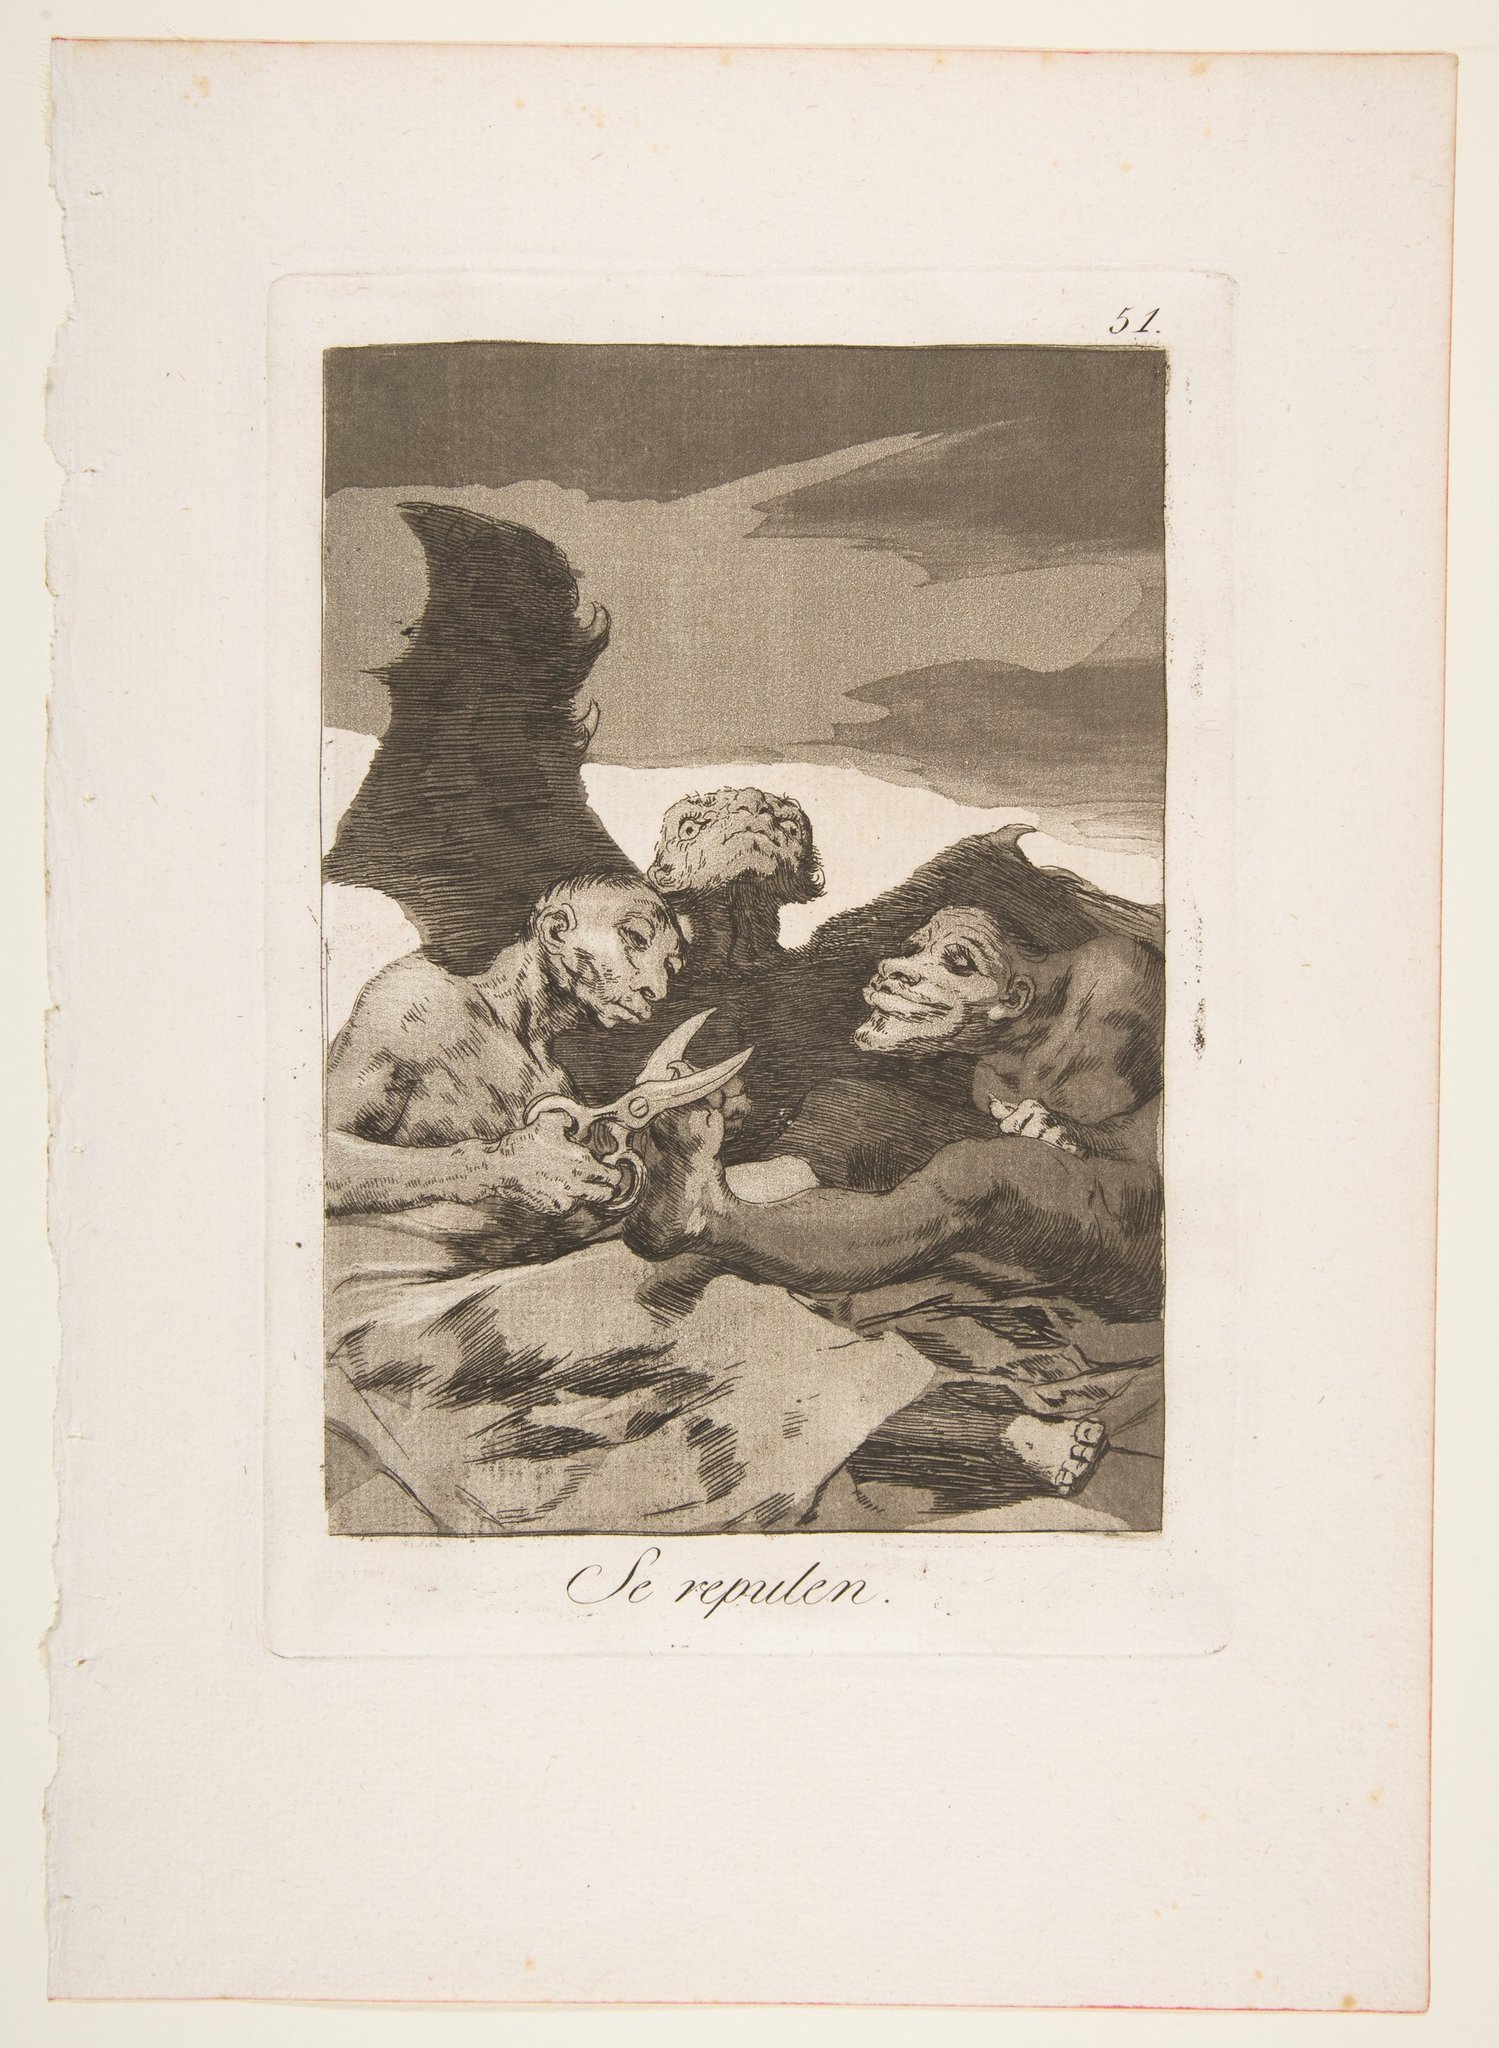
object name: print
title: Plate 51 from "Los Caprichos": They spruce themselves up (Se repulen)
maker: goya (francisco de goya y lucientes)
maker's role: artist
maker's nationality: spanish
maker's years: 1746-1828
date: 1799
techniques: aquatint, engraving, burnishing, etching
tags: mythical creatures,demons,scissors